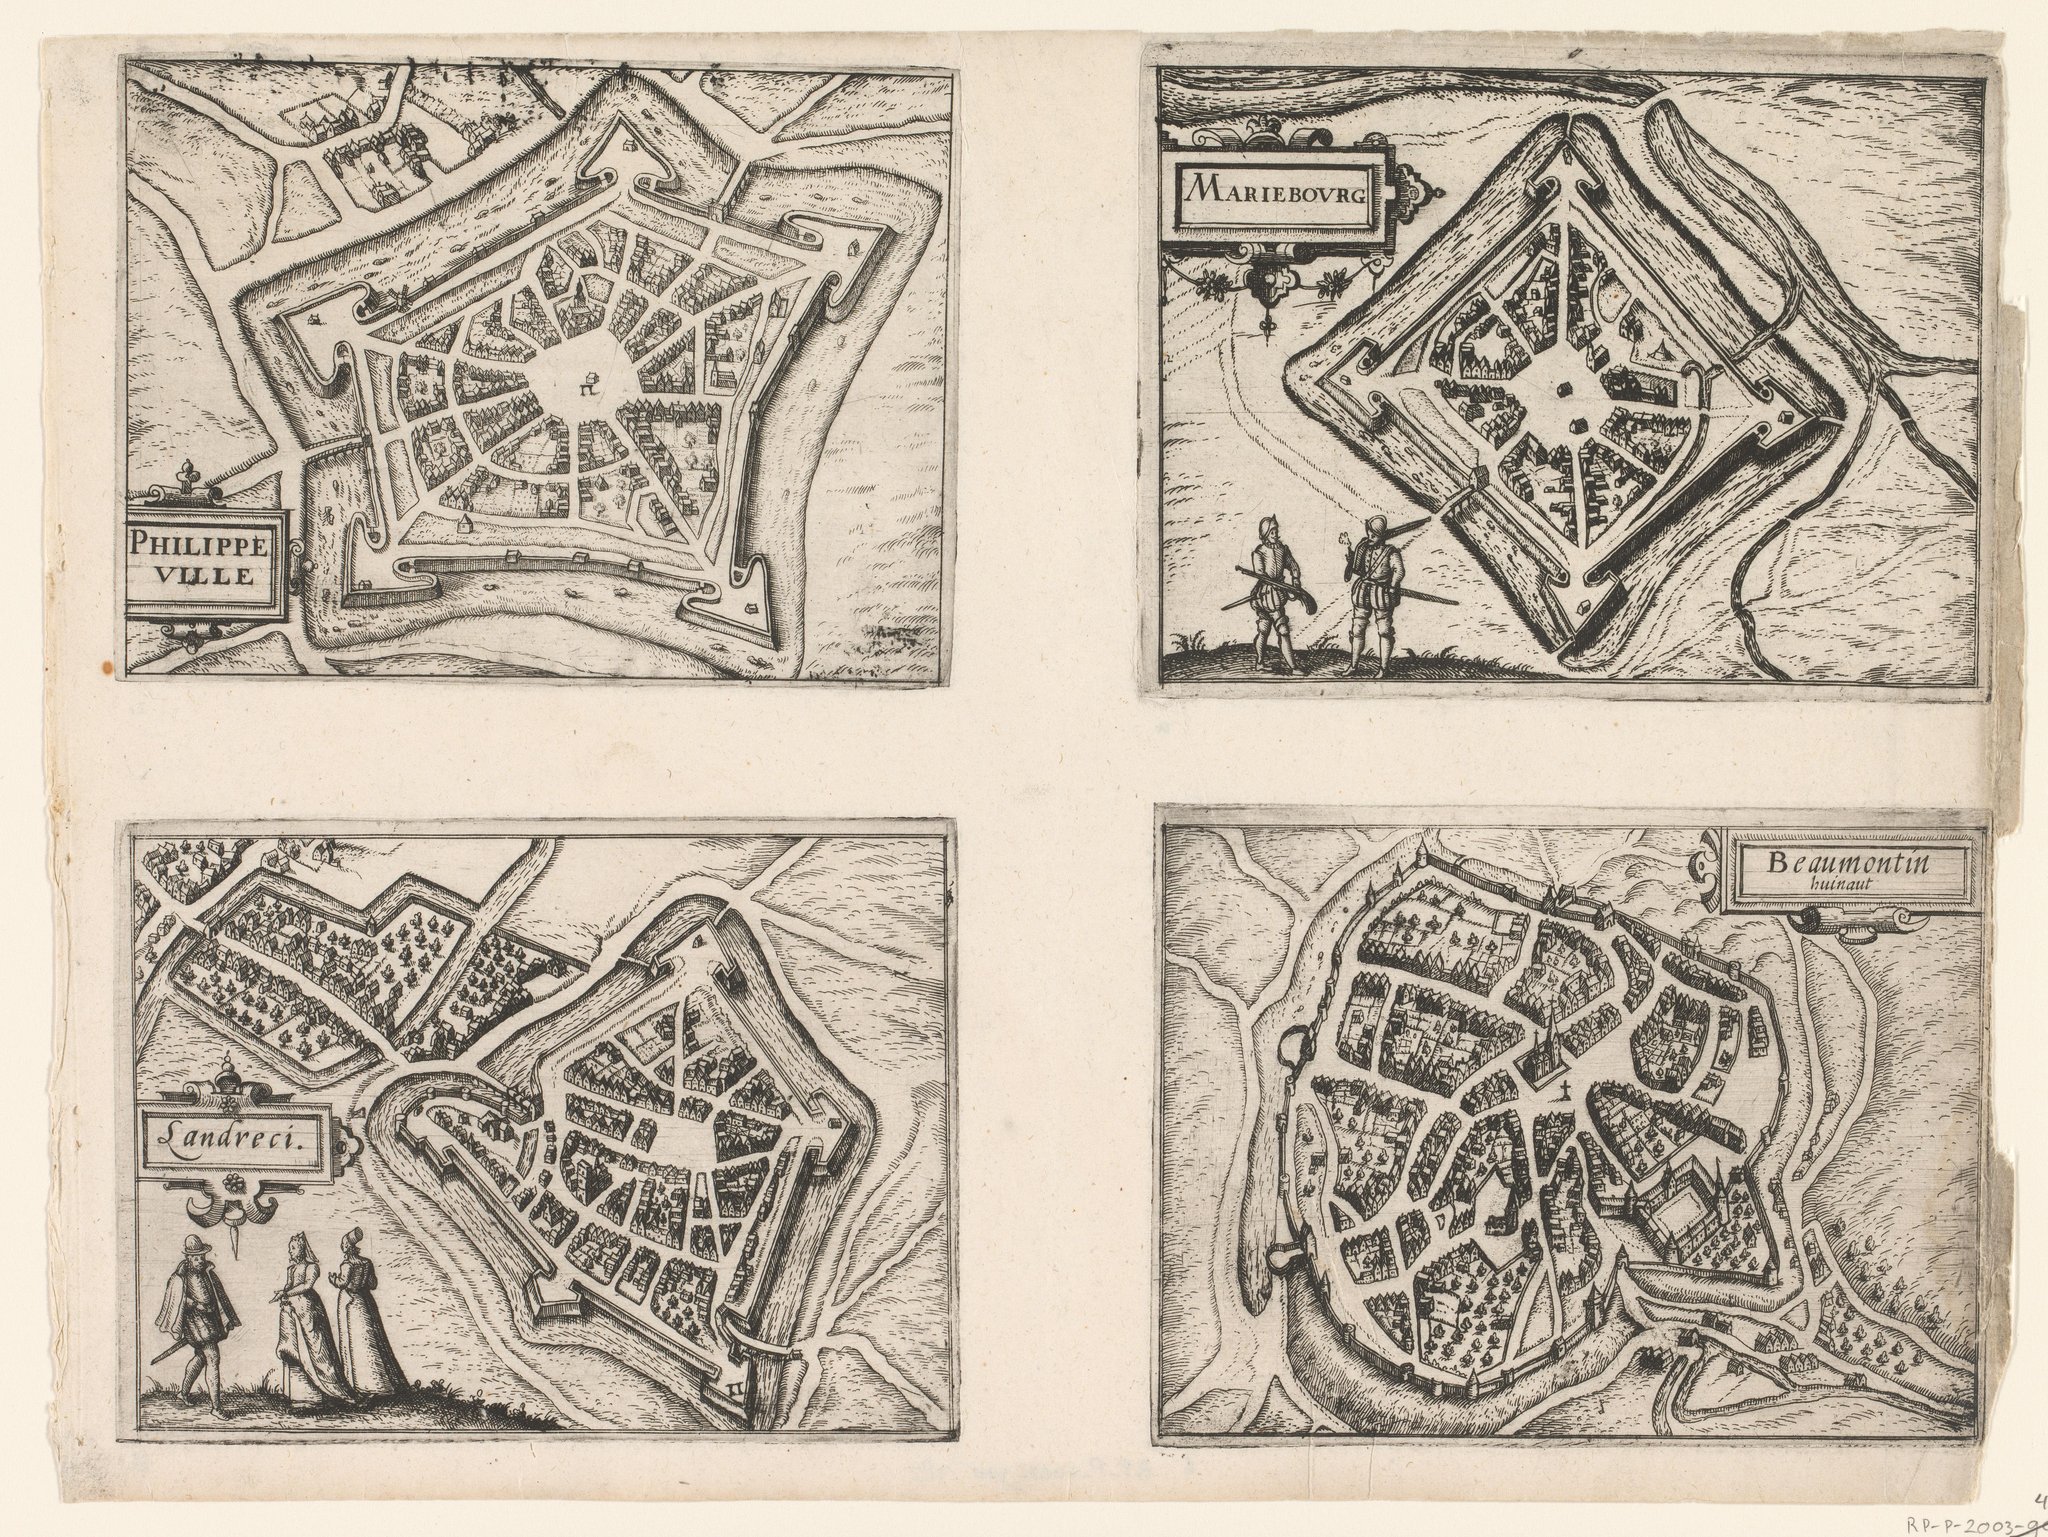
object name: area plan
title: Plattegronden van Philippeville, Mariembourg, Landrecies en Beaumont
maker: Anonymous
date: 1607-1609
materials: paper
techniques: etching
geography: southern netherlands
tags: maps of cities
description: Blad met vier plattegronden van de steden Philippeville, Mariembourg, Landrecies (Landeschie) en Beaumont, op één blad gedrukt van afzonderlijke platen. Onderdeel van de verzameling kaarten genomen uit een latere editie van: Descrittione di tutti i Paesi Bassi van Lodovico Guicciardini.